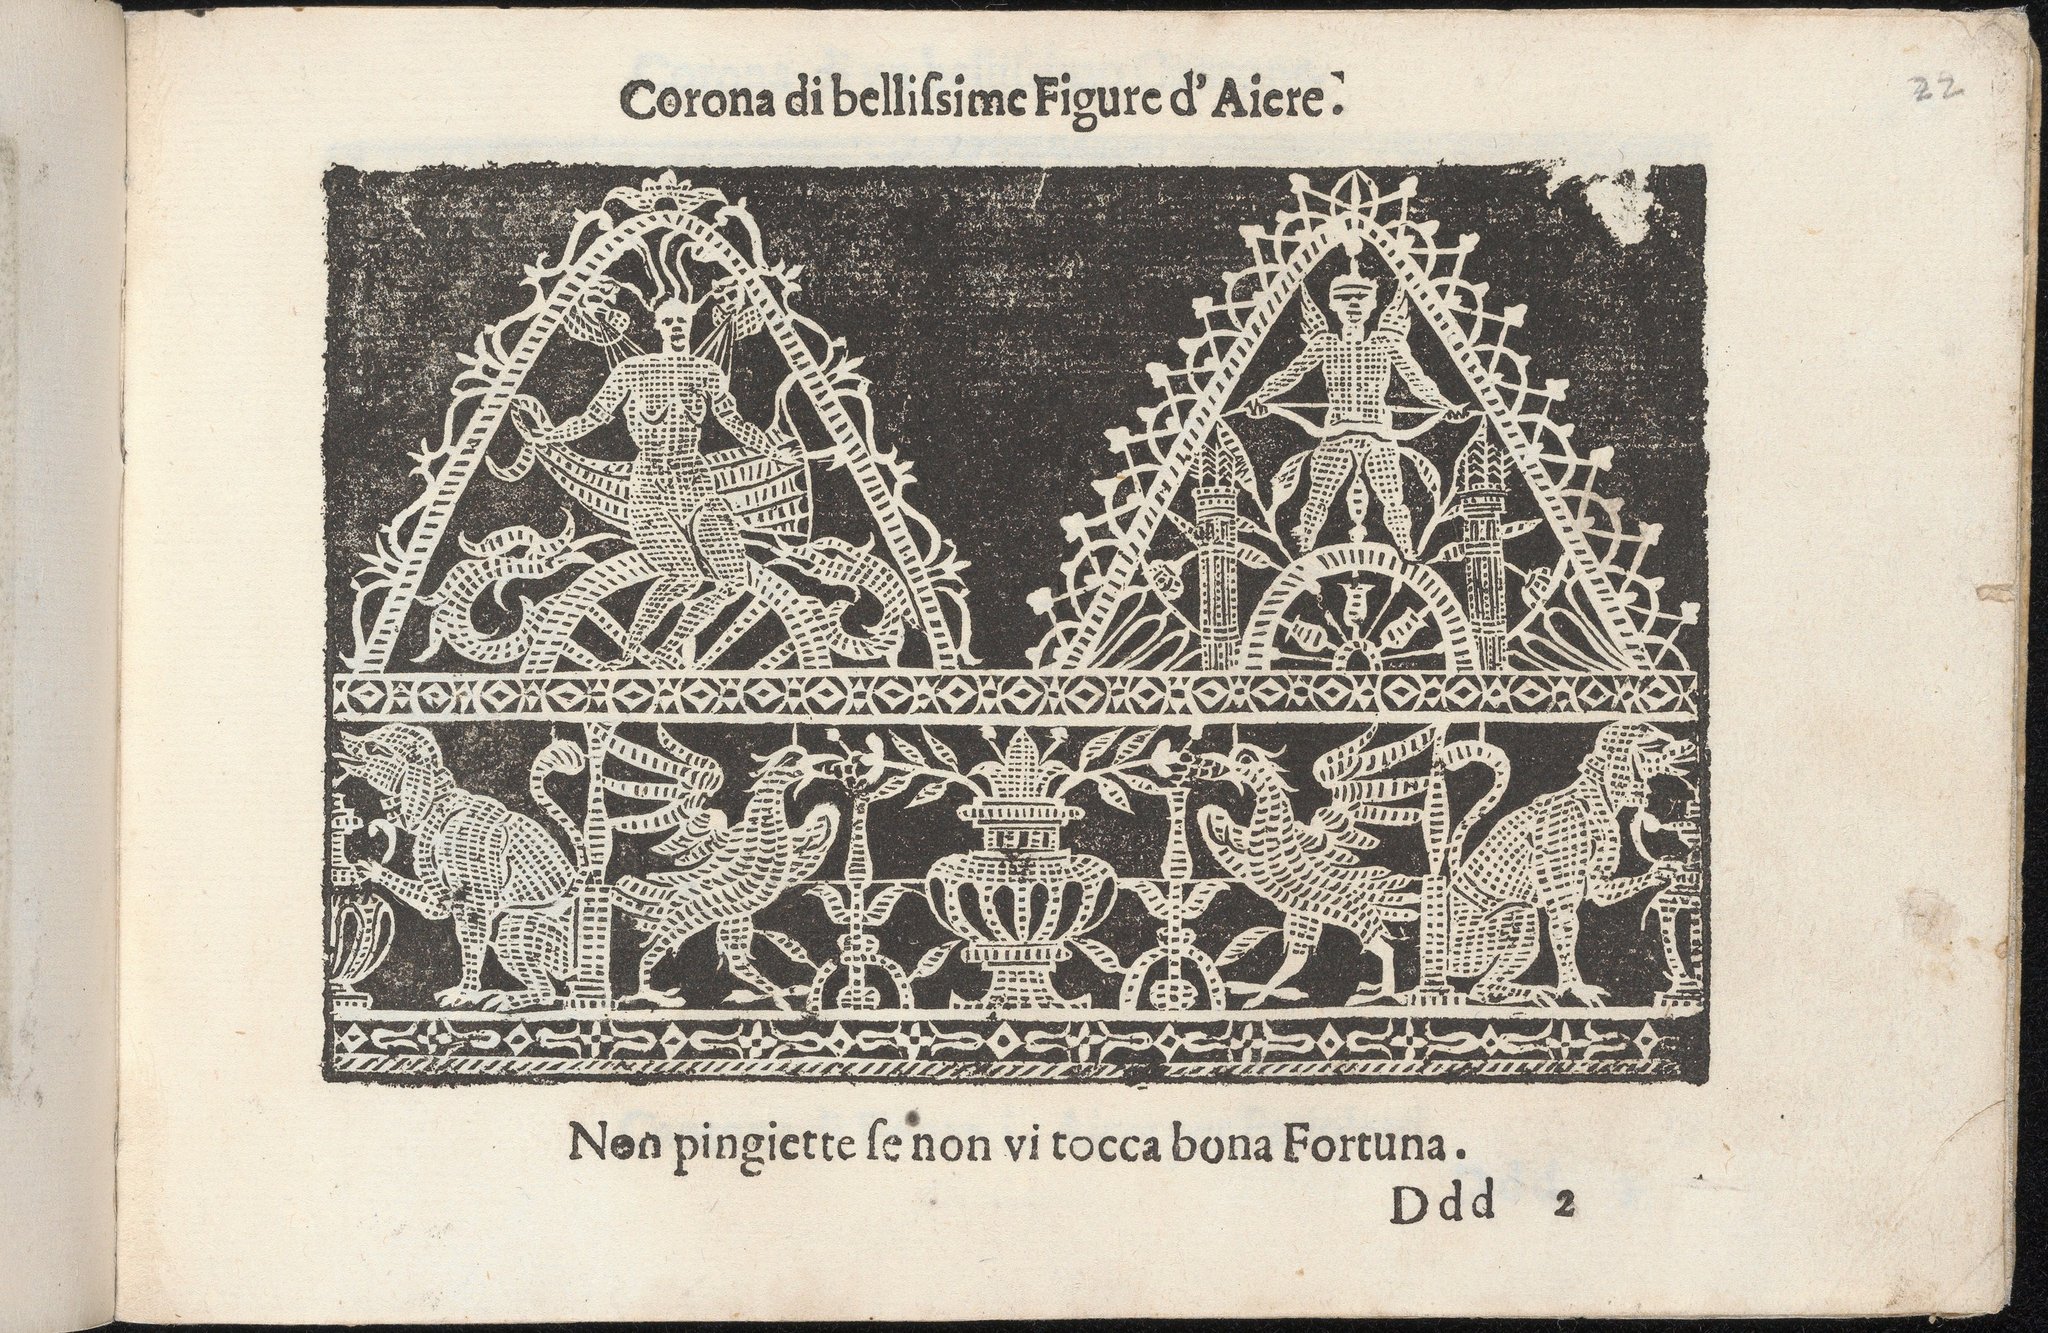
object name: book print ornament architecture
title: Corona delle Nobile et Virtuose Donne, Libro Terzo, page 22 (recto)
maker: cesare vecellio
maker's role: designer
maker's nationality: italian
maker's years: 1521-1601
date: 1620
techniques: woodcut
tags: birds,male nudes,female nudes,serpents